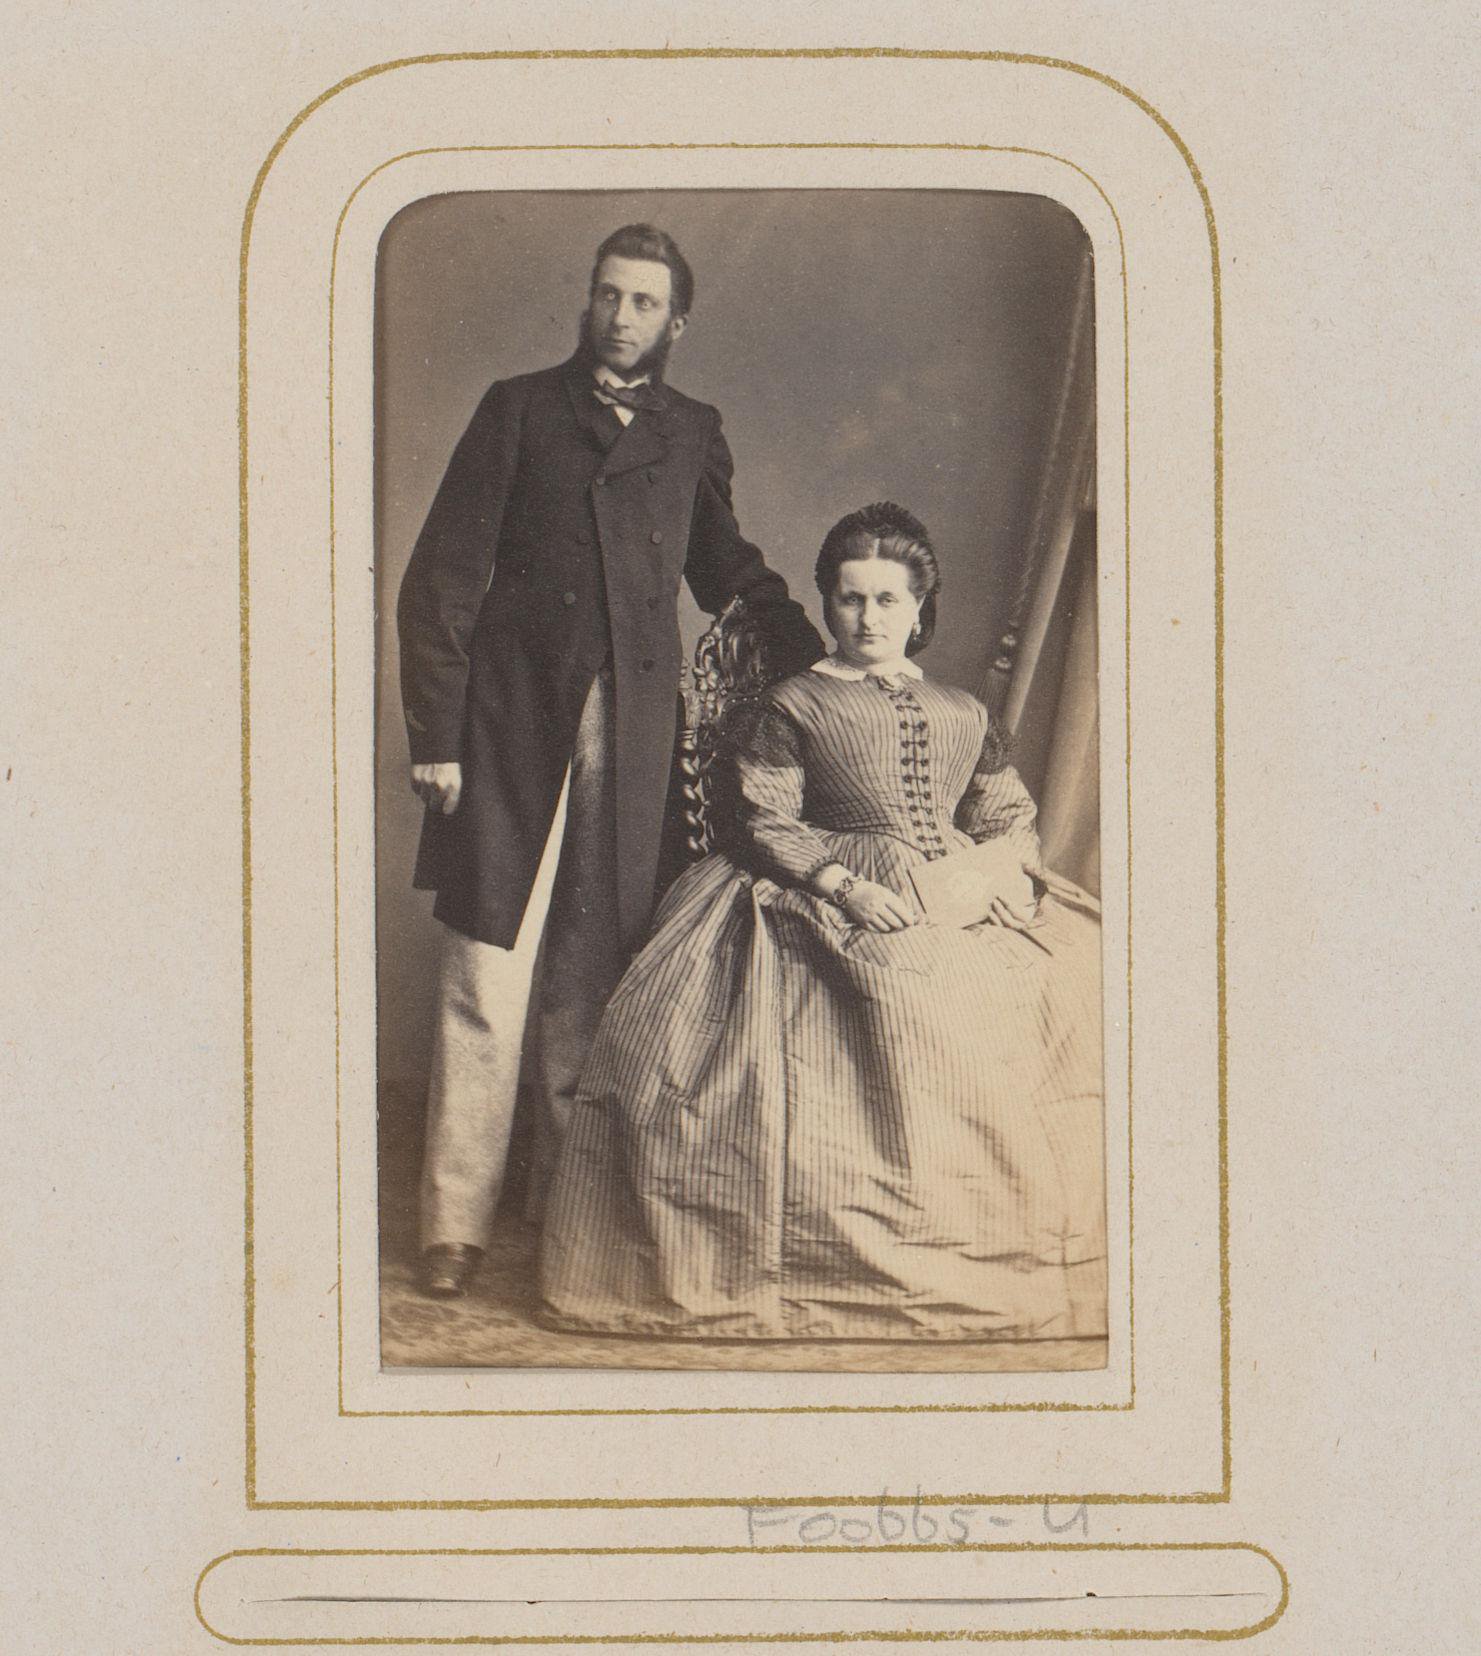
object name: carte de visite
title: Portret van een man en vrouw met boek in hand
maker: Anonymous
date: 1855-1880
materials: cardboard, photographic support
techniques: albumen print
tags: historical persons - bb - woman, historical persons